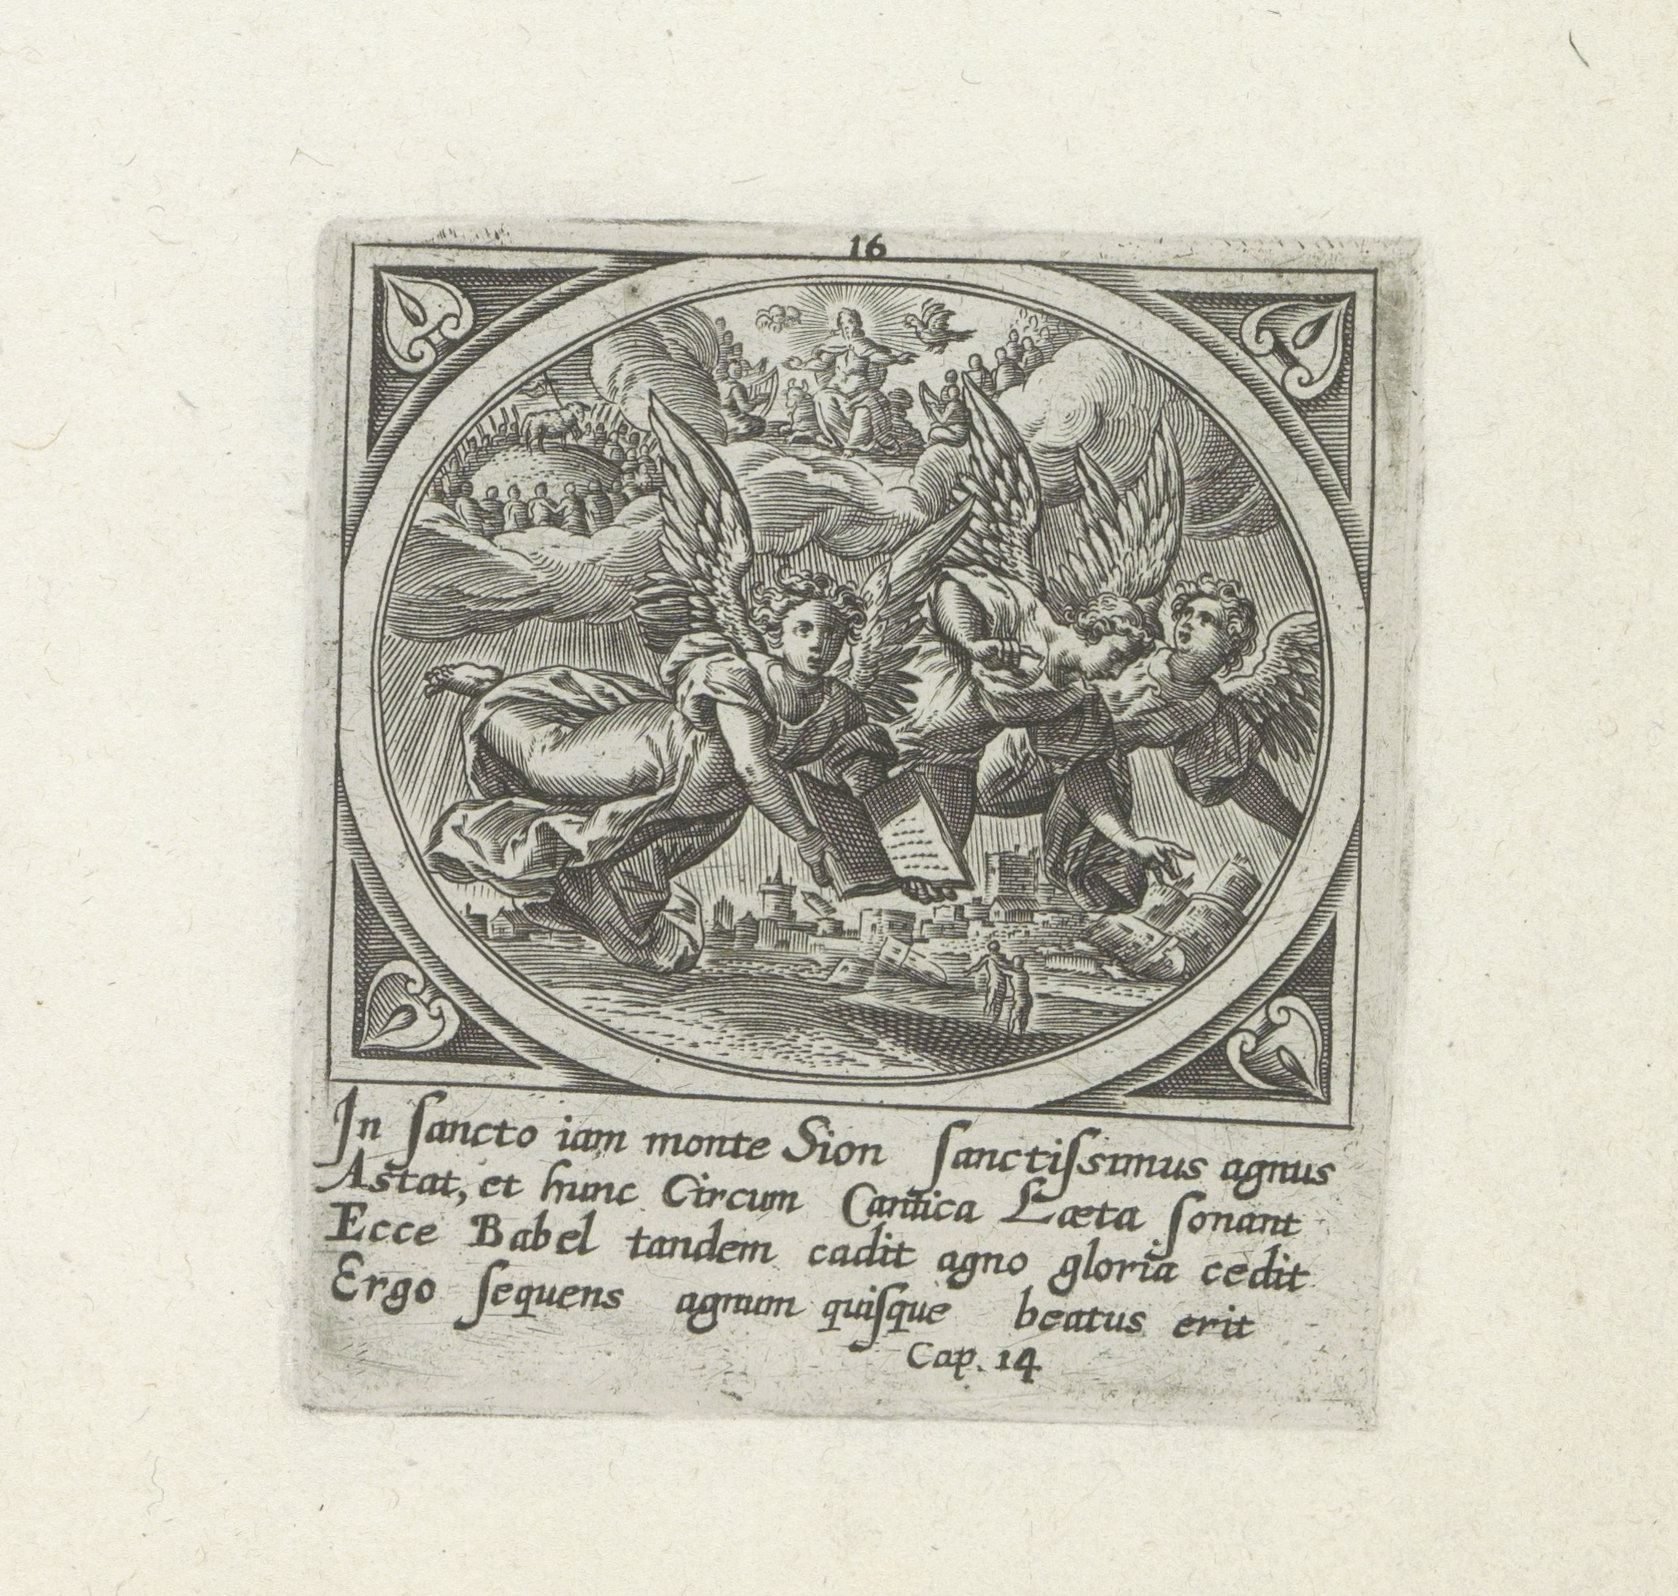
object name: print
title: Icones Revelationum S Iohs Evangeliste in Pathmo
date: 1585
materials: paper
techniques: engraving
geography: antwerp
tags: the three angels proclaiming the day of judgement, adoration of the lamb on mount sion by the 144-thousand ~ apocalypse (+ angel(s) floating in the air)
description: Het Lam op de berg Sion omringd door mensen. God de Vader op zijn troon, omringd door de vier wezens en de oudsten. In het midden drie engelen: de eerste houdt het eeuwige evangelie vast en kondigt de dag des oordeels aan, de tweede de val van Babylon. De derde engel waarschuwt tegen de aanbidding van het beest en het beeld, want als straf zal men de wijn van Gods woede moeten drinken. Onder de voorstelling een verwijzing in het Latijn naar de Bijbeltekst in Op. 14. Deze prent maakt deel uit van een album.